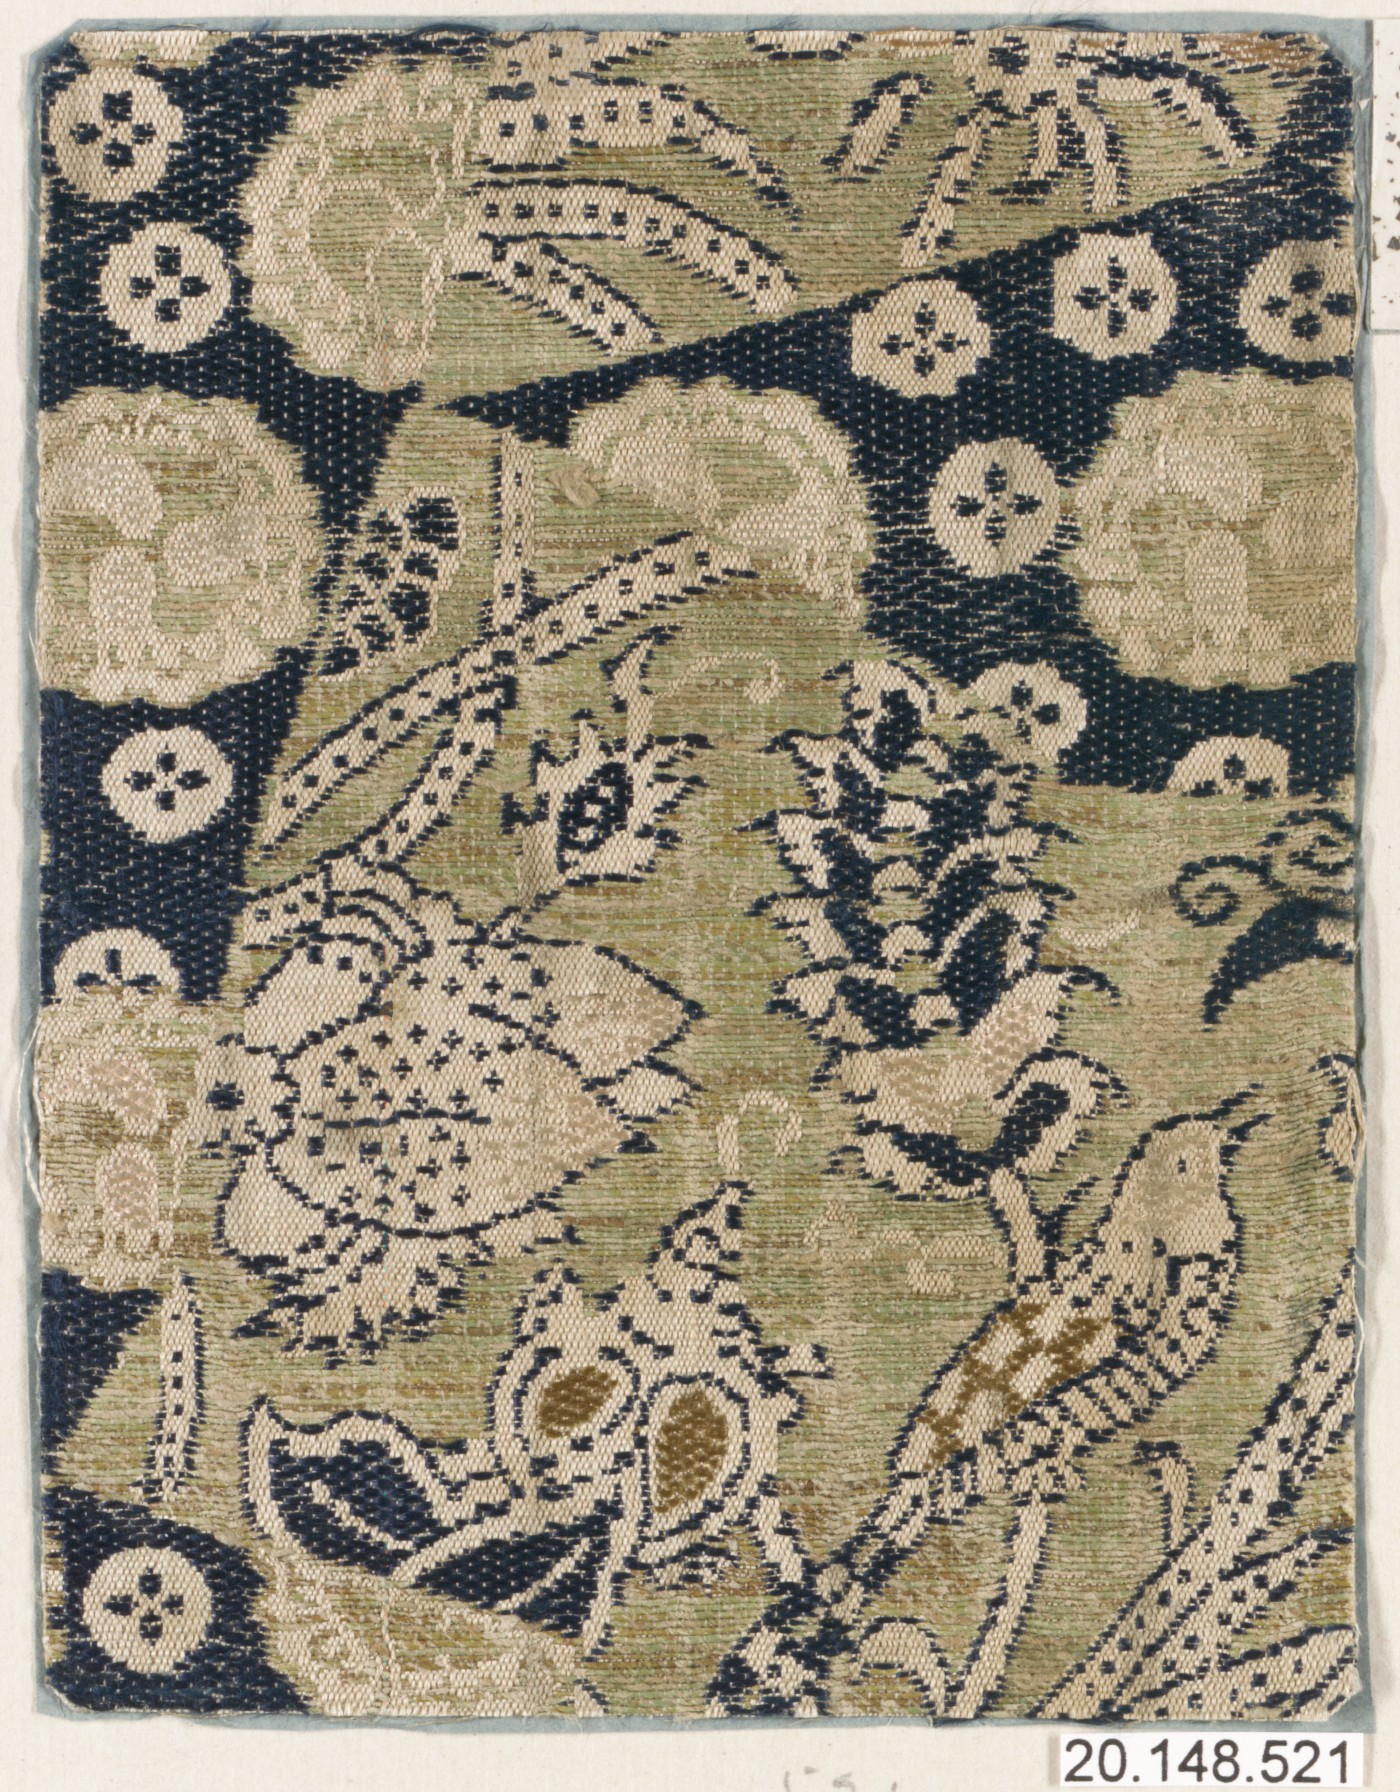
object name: piece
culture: japanese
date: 1701-1800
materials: silk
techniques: compound weave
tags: birds,flowers